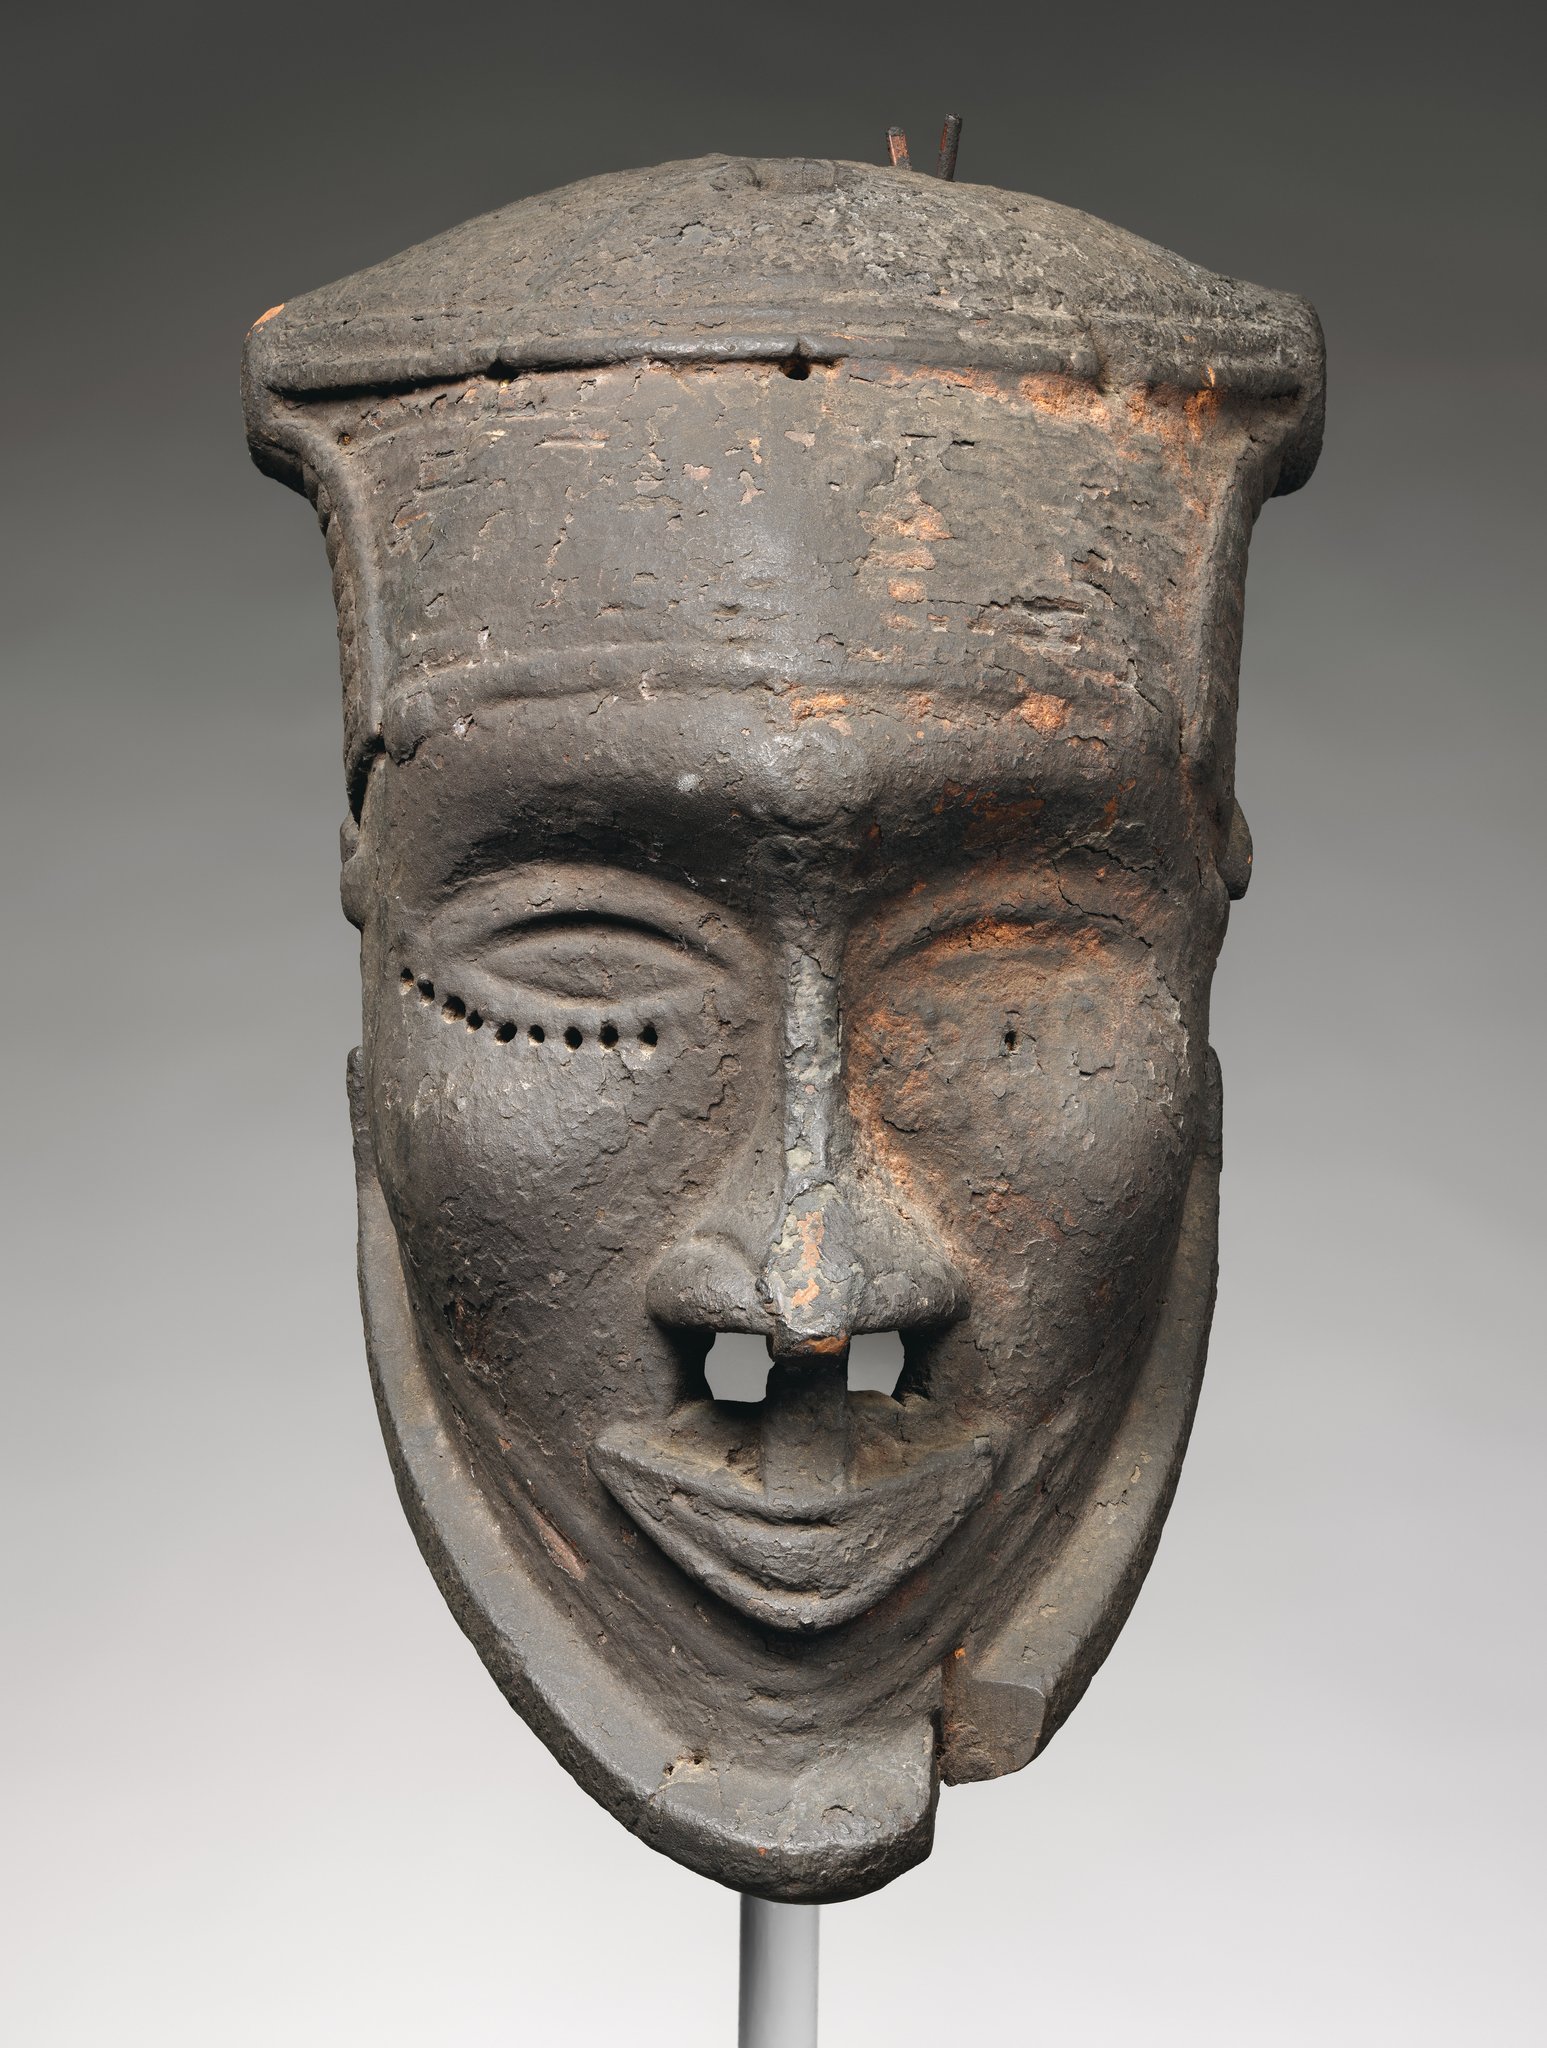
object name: mask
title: Helmet mask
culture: kuba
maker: ngeende-kuba artist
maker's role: artist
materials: wood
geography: democratic republic of the congo